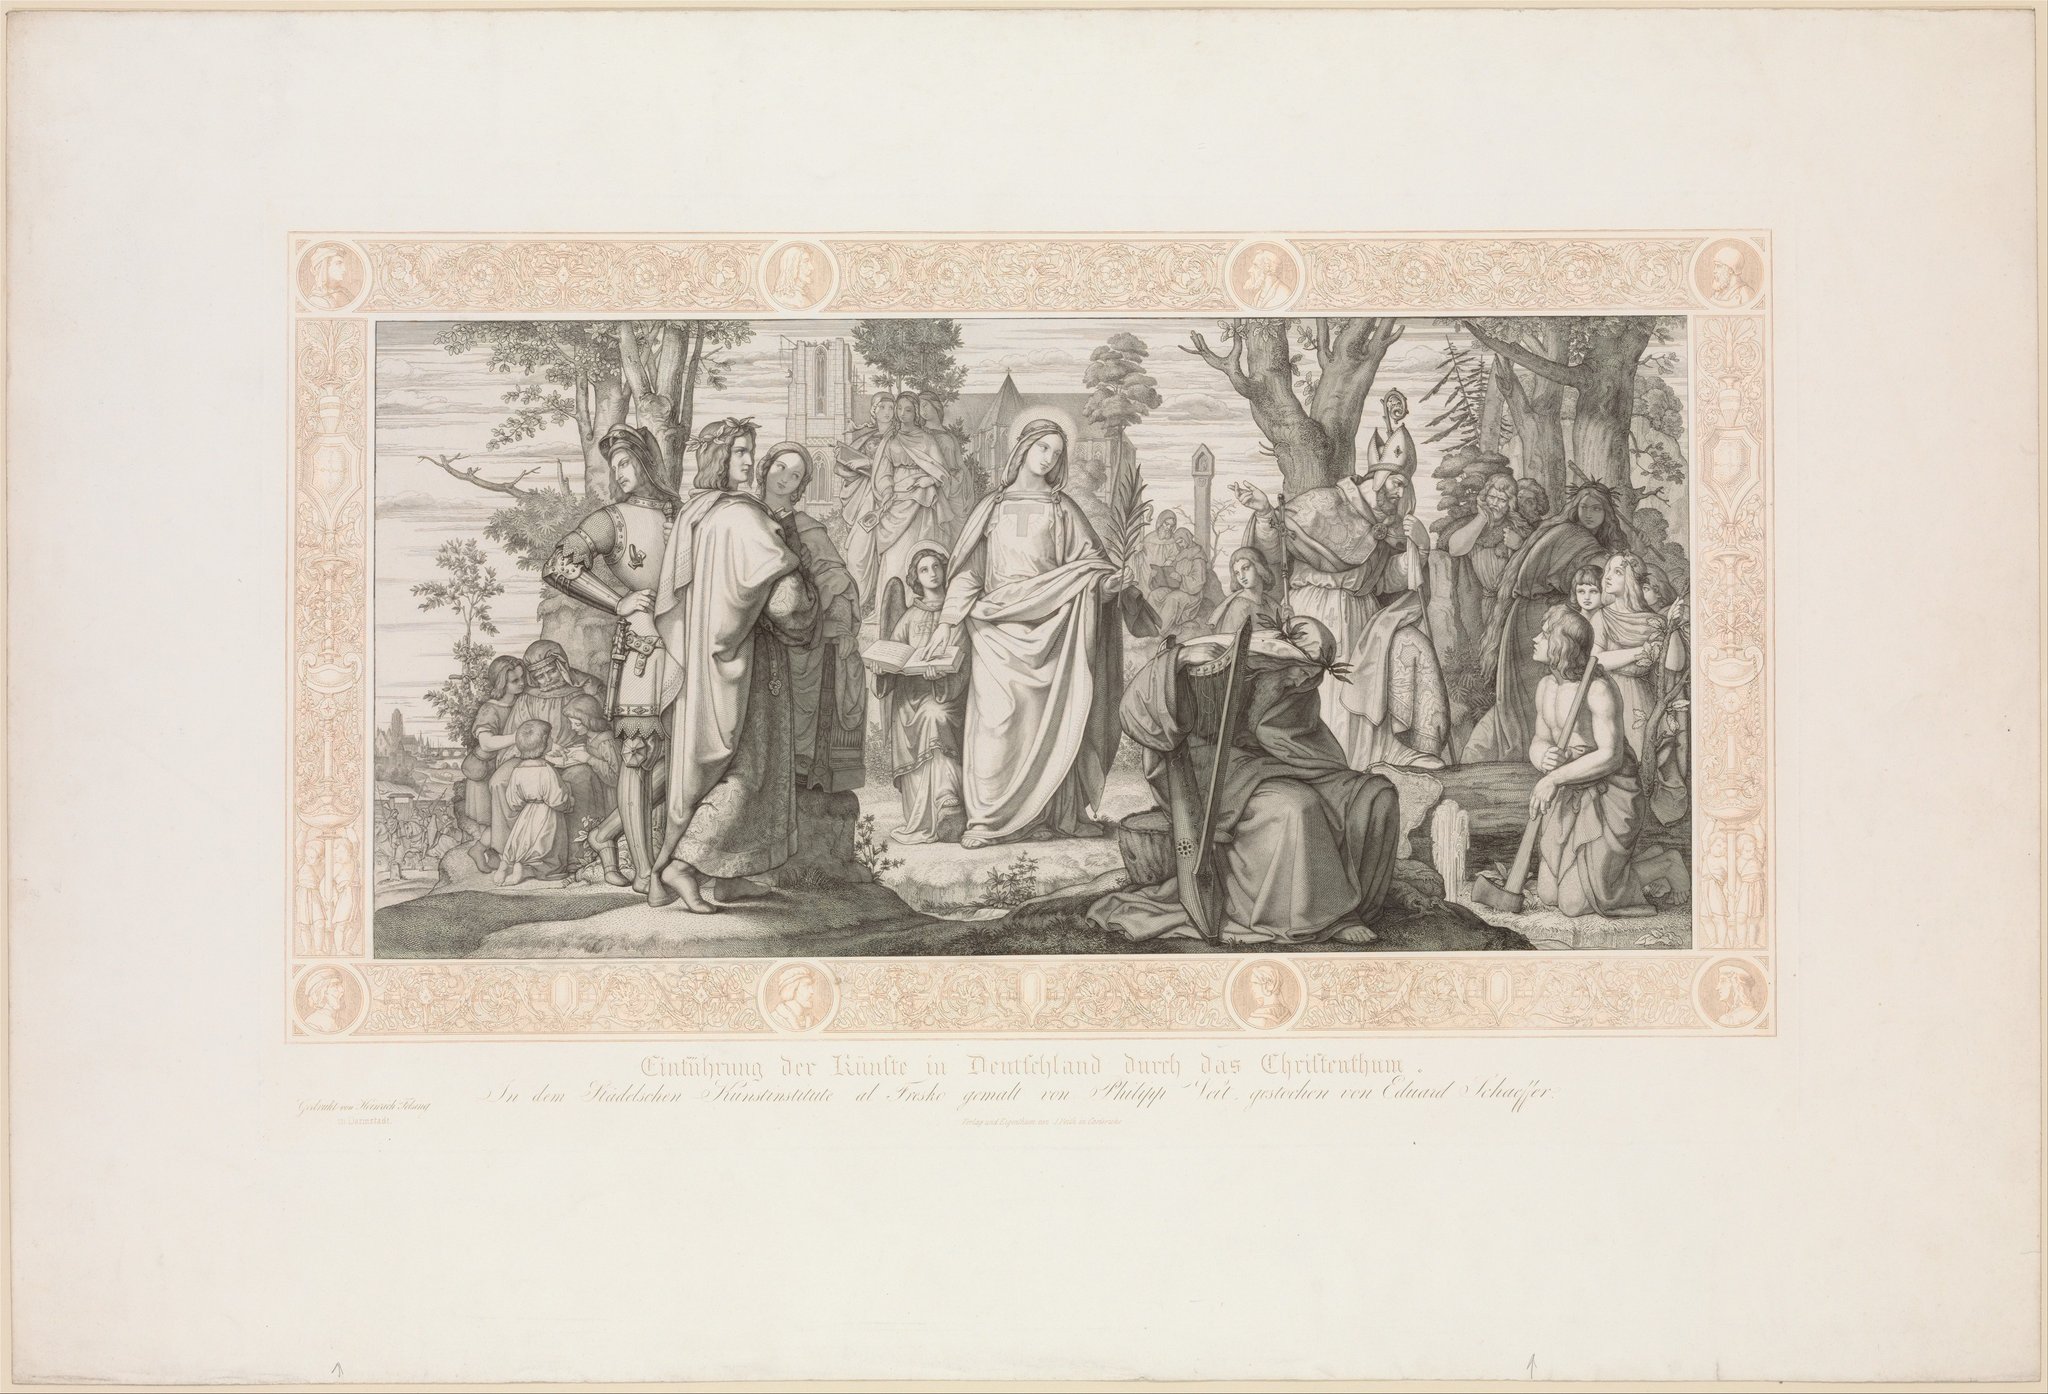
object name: print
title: The Introduction of the arts in German by Christianity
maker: eugen eduard schäffer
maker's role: artist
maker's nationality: german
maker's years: 1802-1871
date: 1839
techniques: engraving, etching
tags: men,women,trees